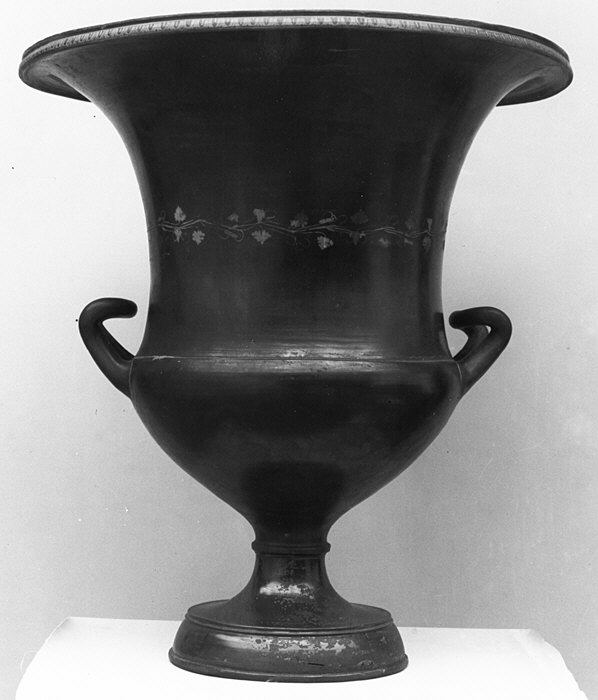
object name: calyx krater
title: Terracotta calyx-krater (bowl for mixing wine and water)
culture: greek, attic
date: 400-301 BCE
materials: terracotta